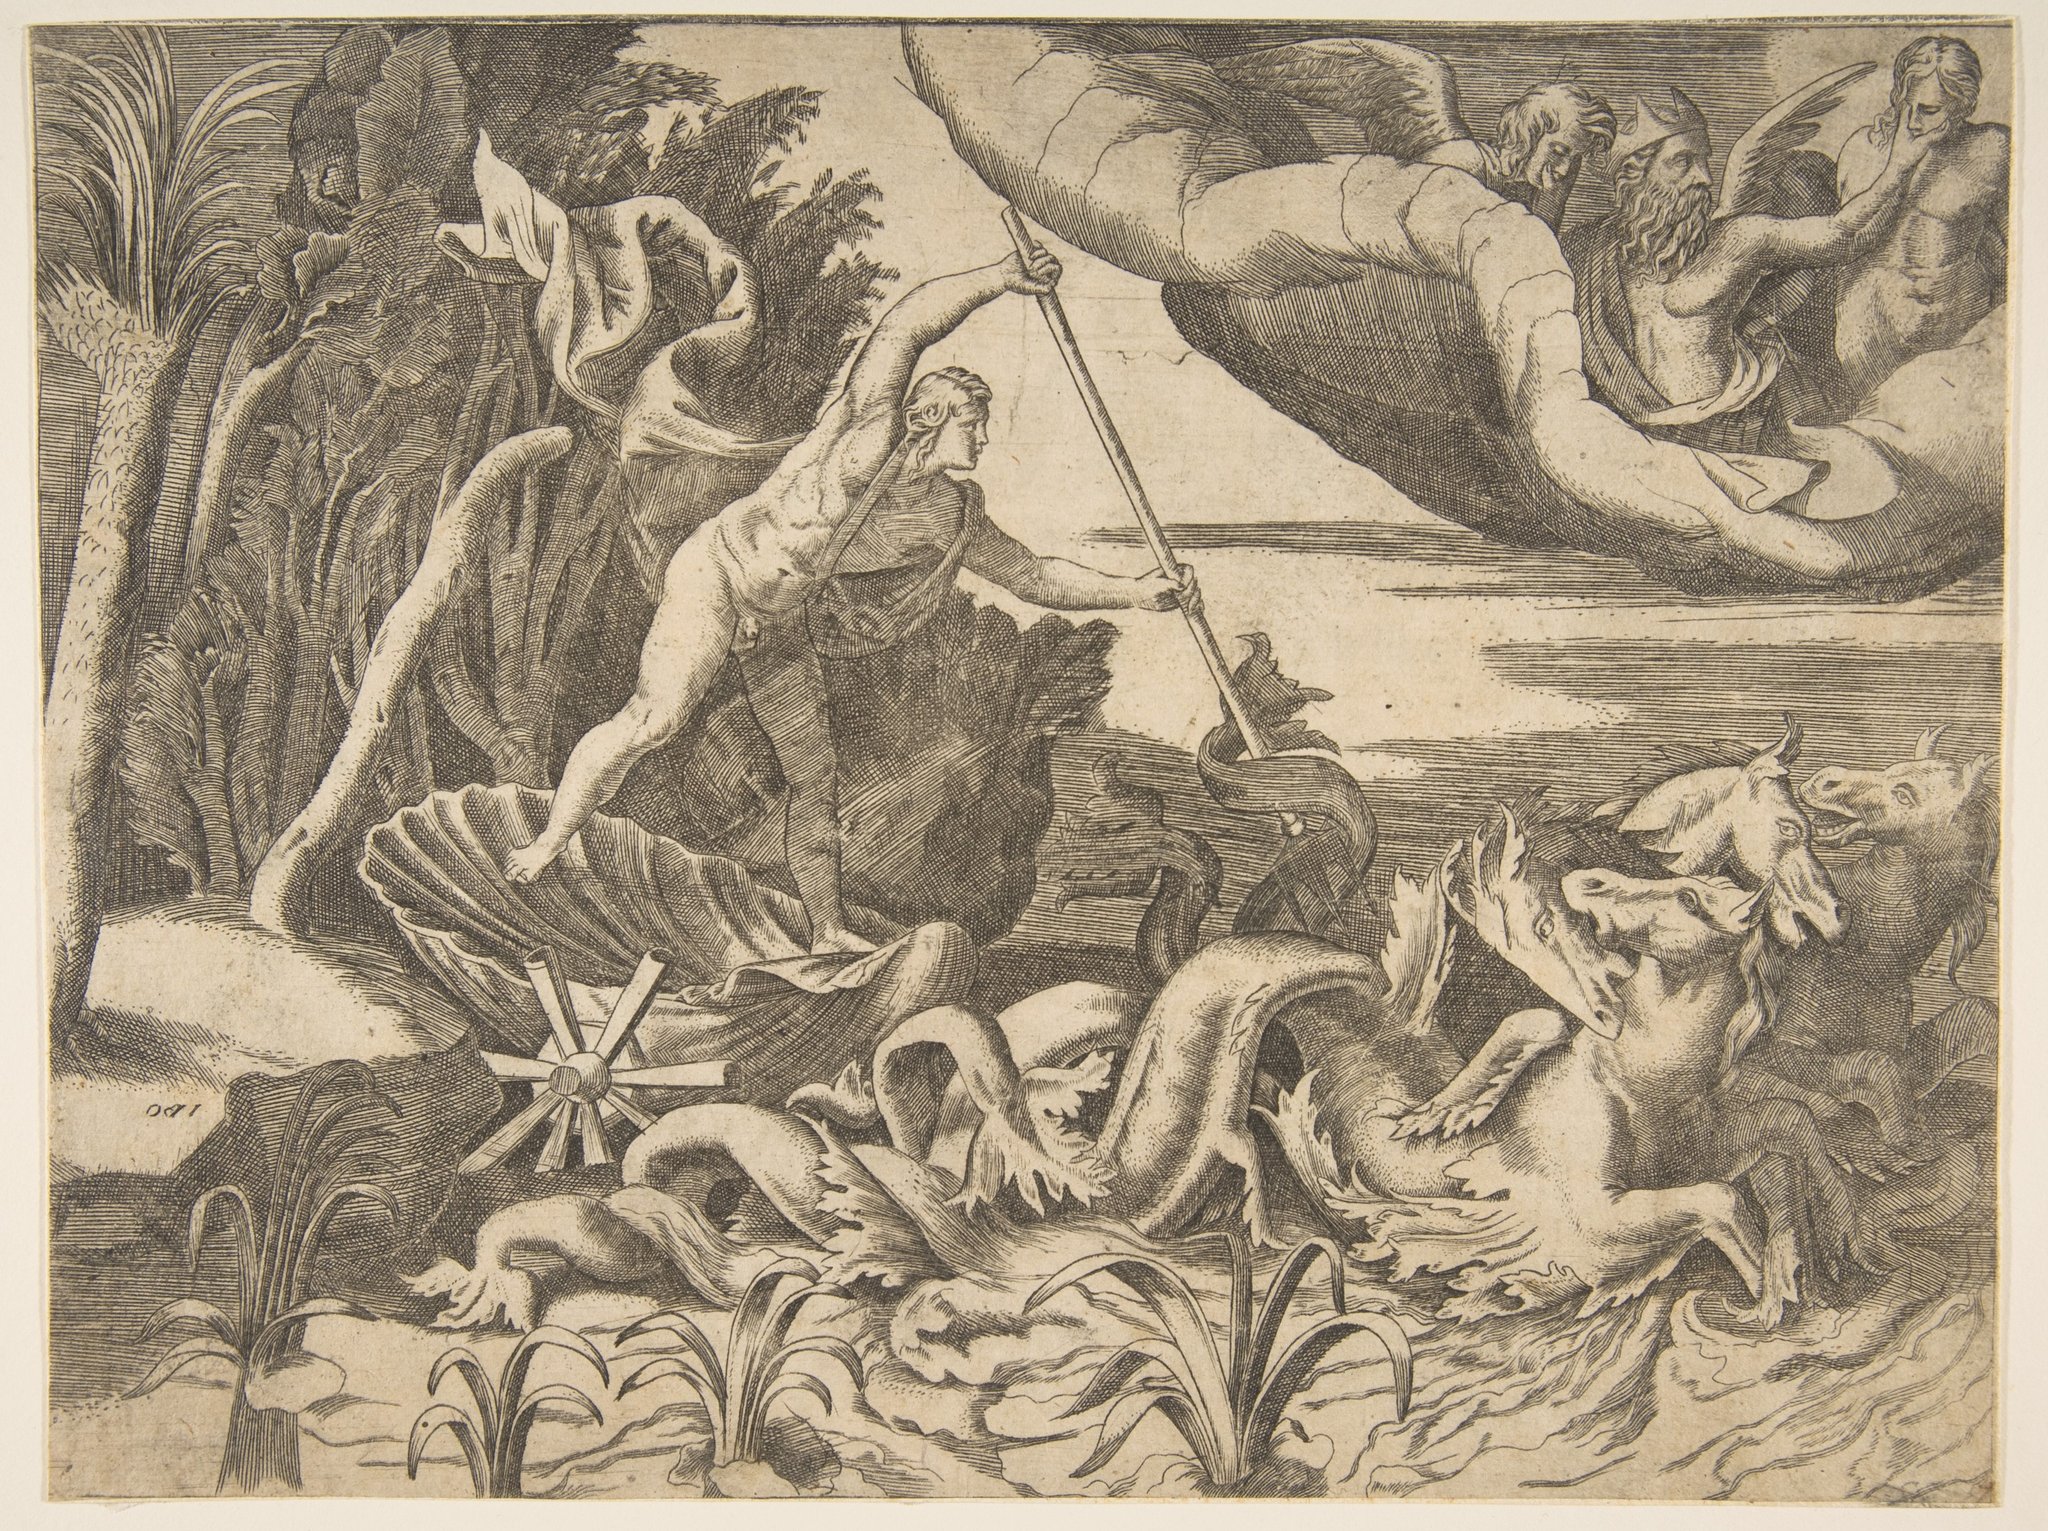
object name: print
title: Neptune in his Chariot being drawn by seahorses, from the 'Division of the Universe'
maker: giulio bonasone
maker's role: artist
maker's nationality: italian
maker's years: 1510-1576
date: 1531-1576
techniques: engraving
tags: mythical creatures,neptune,shells,chariots,seahorses